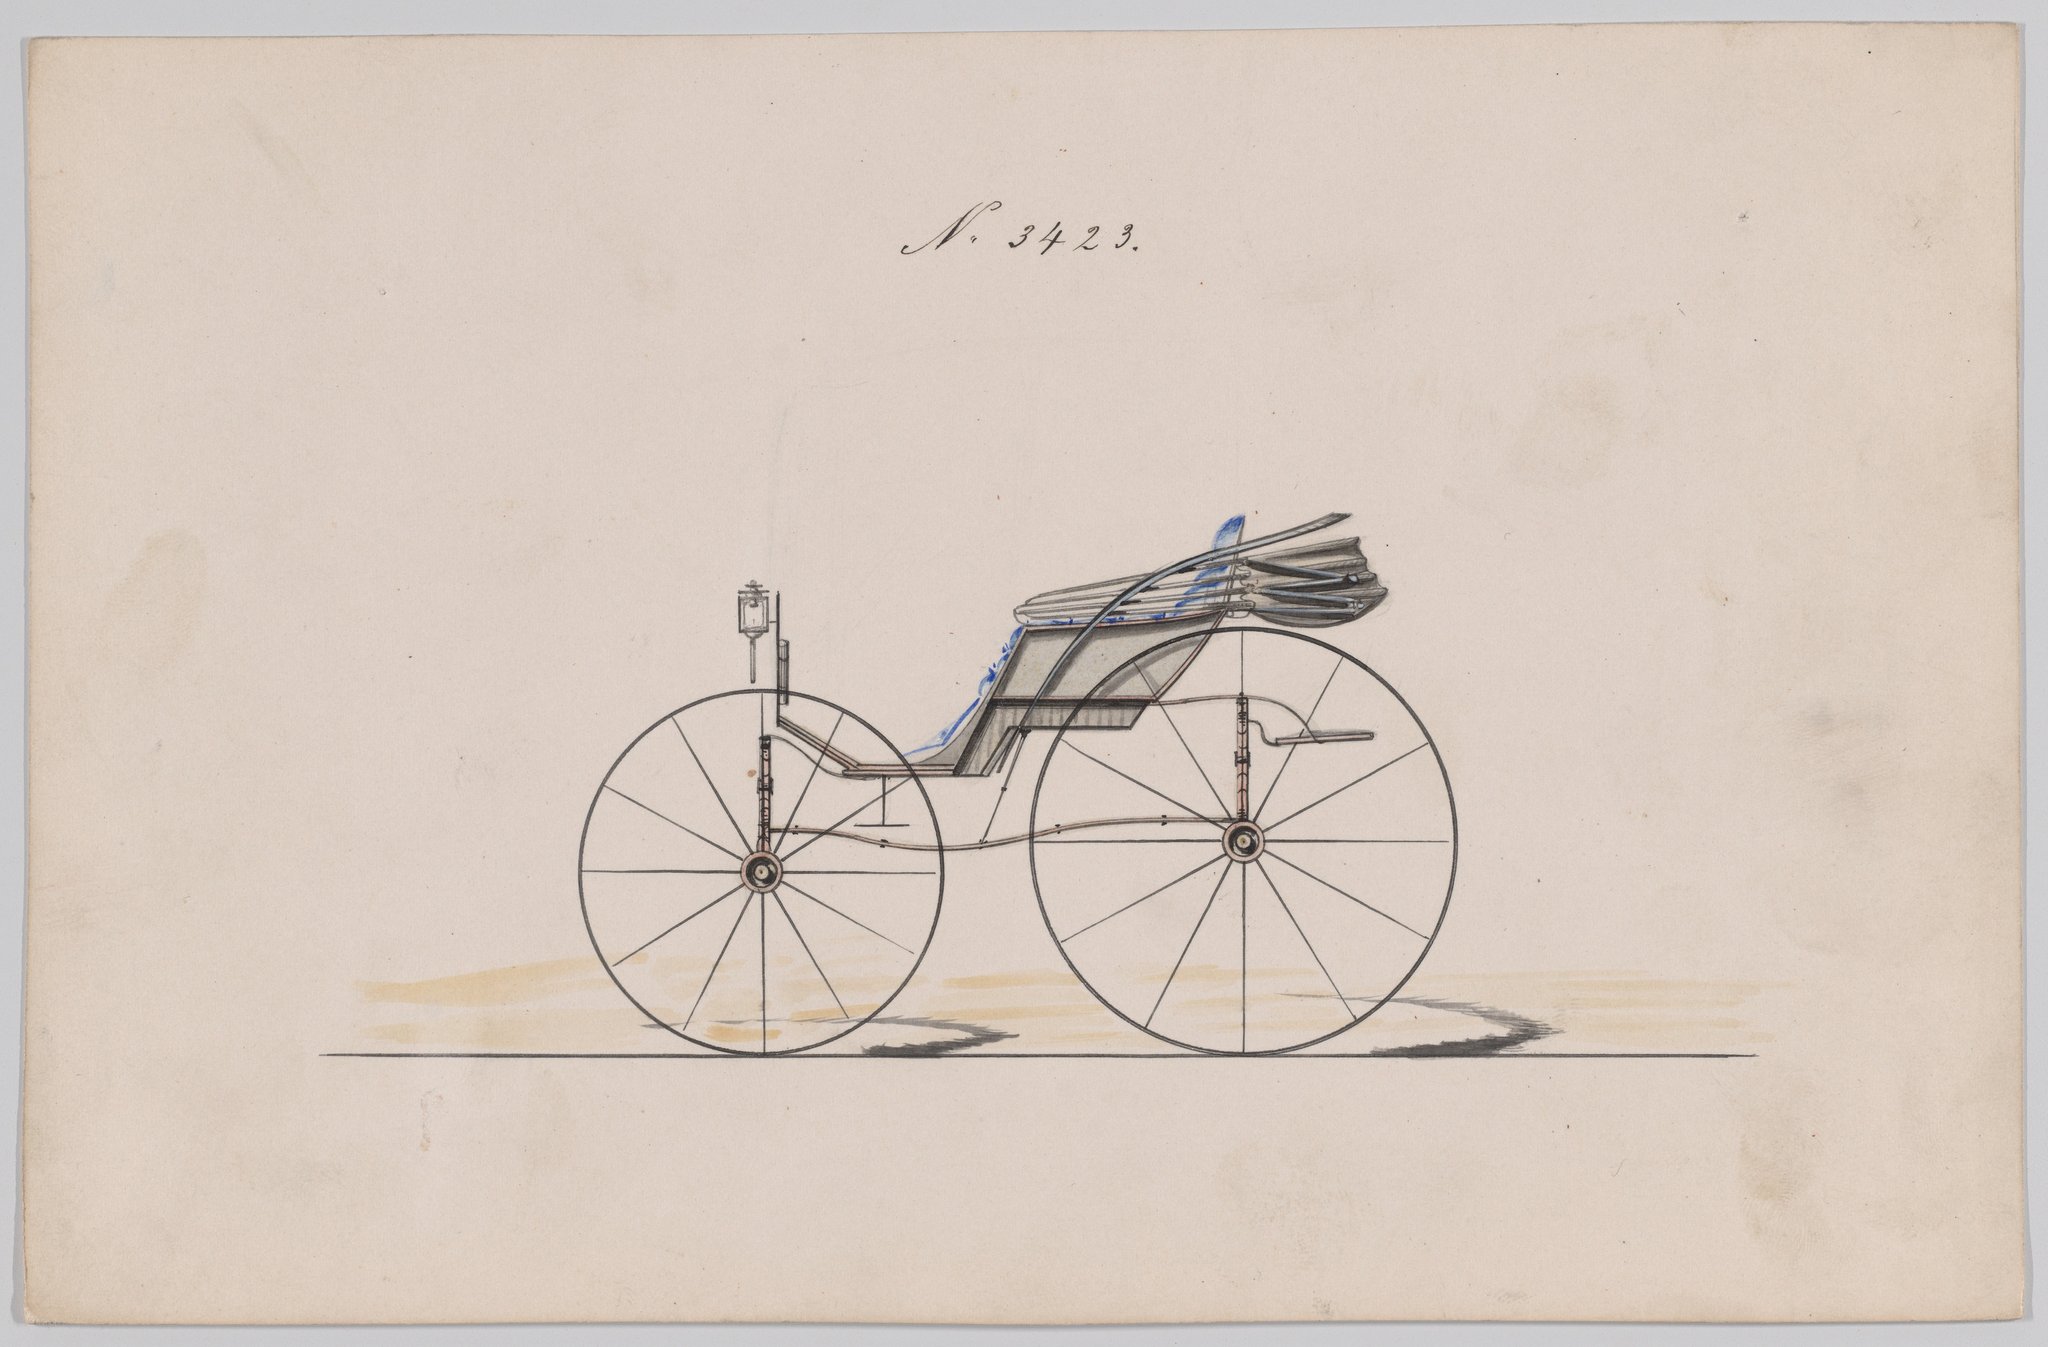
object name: drawing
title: Design for Pony Phaeton, no. 3423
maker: brewster & co.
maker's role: manufacturer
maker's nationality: american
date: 1878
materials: gouache, gum arabic, ink, watercolor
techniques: pen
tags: carriages